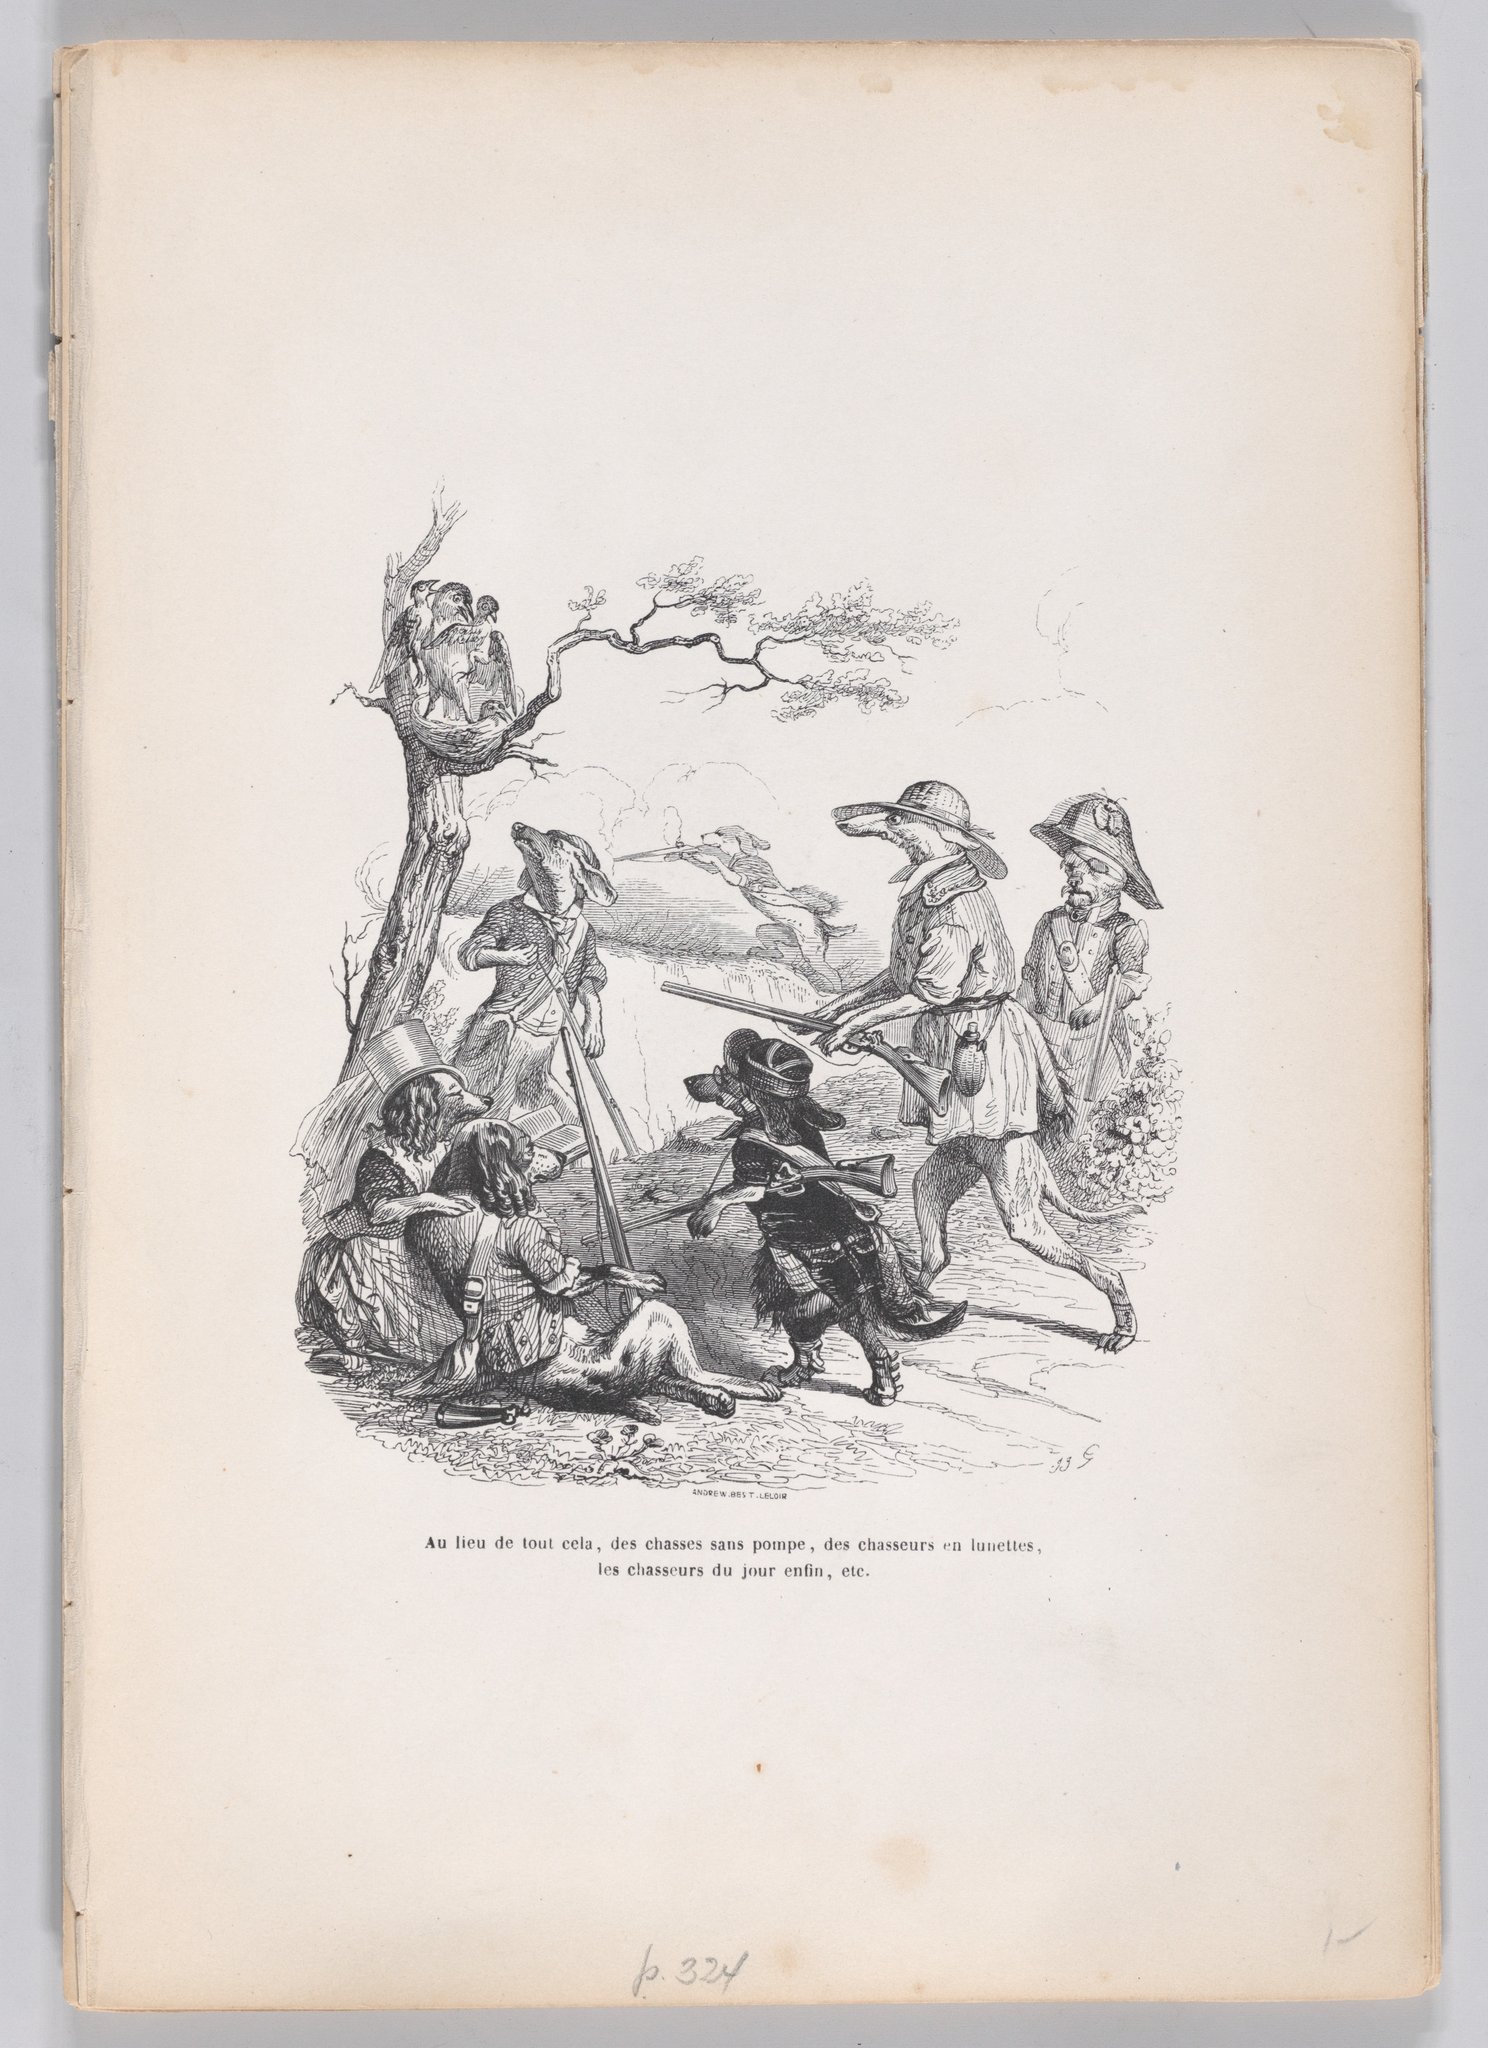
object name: print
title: Instead of all this..., from "Scenes from the Private and Public Life of Animals"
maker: j. j. grandville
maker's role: illustrator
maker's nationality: french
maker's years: 1803-1847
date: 1837-1847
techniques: engraving